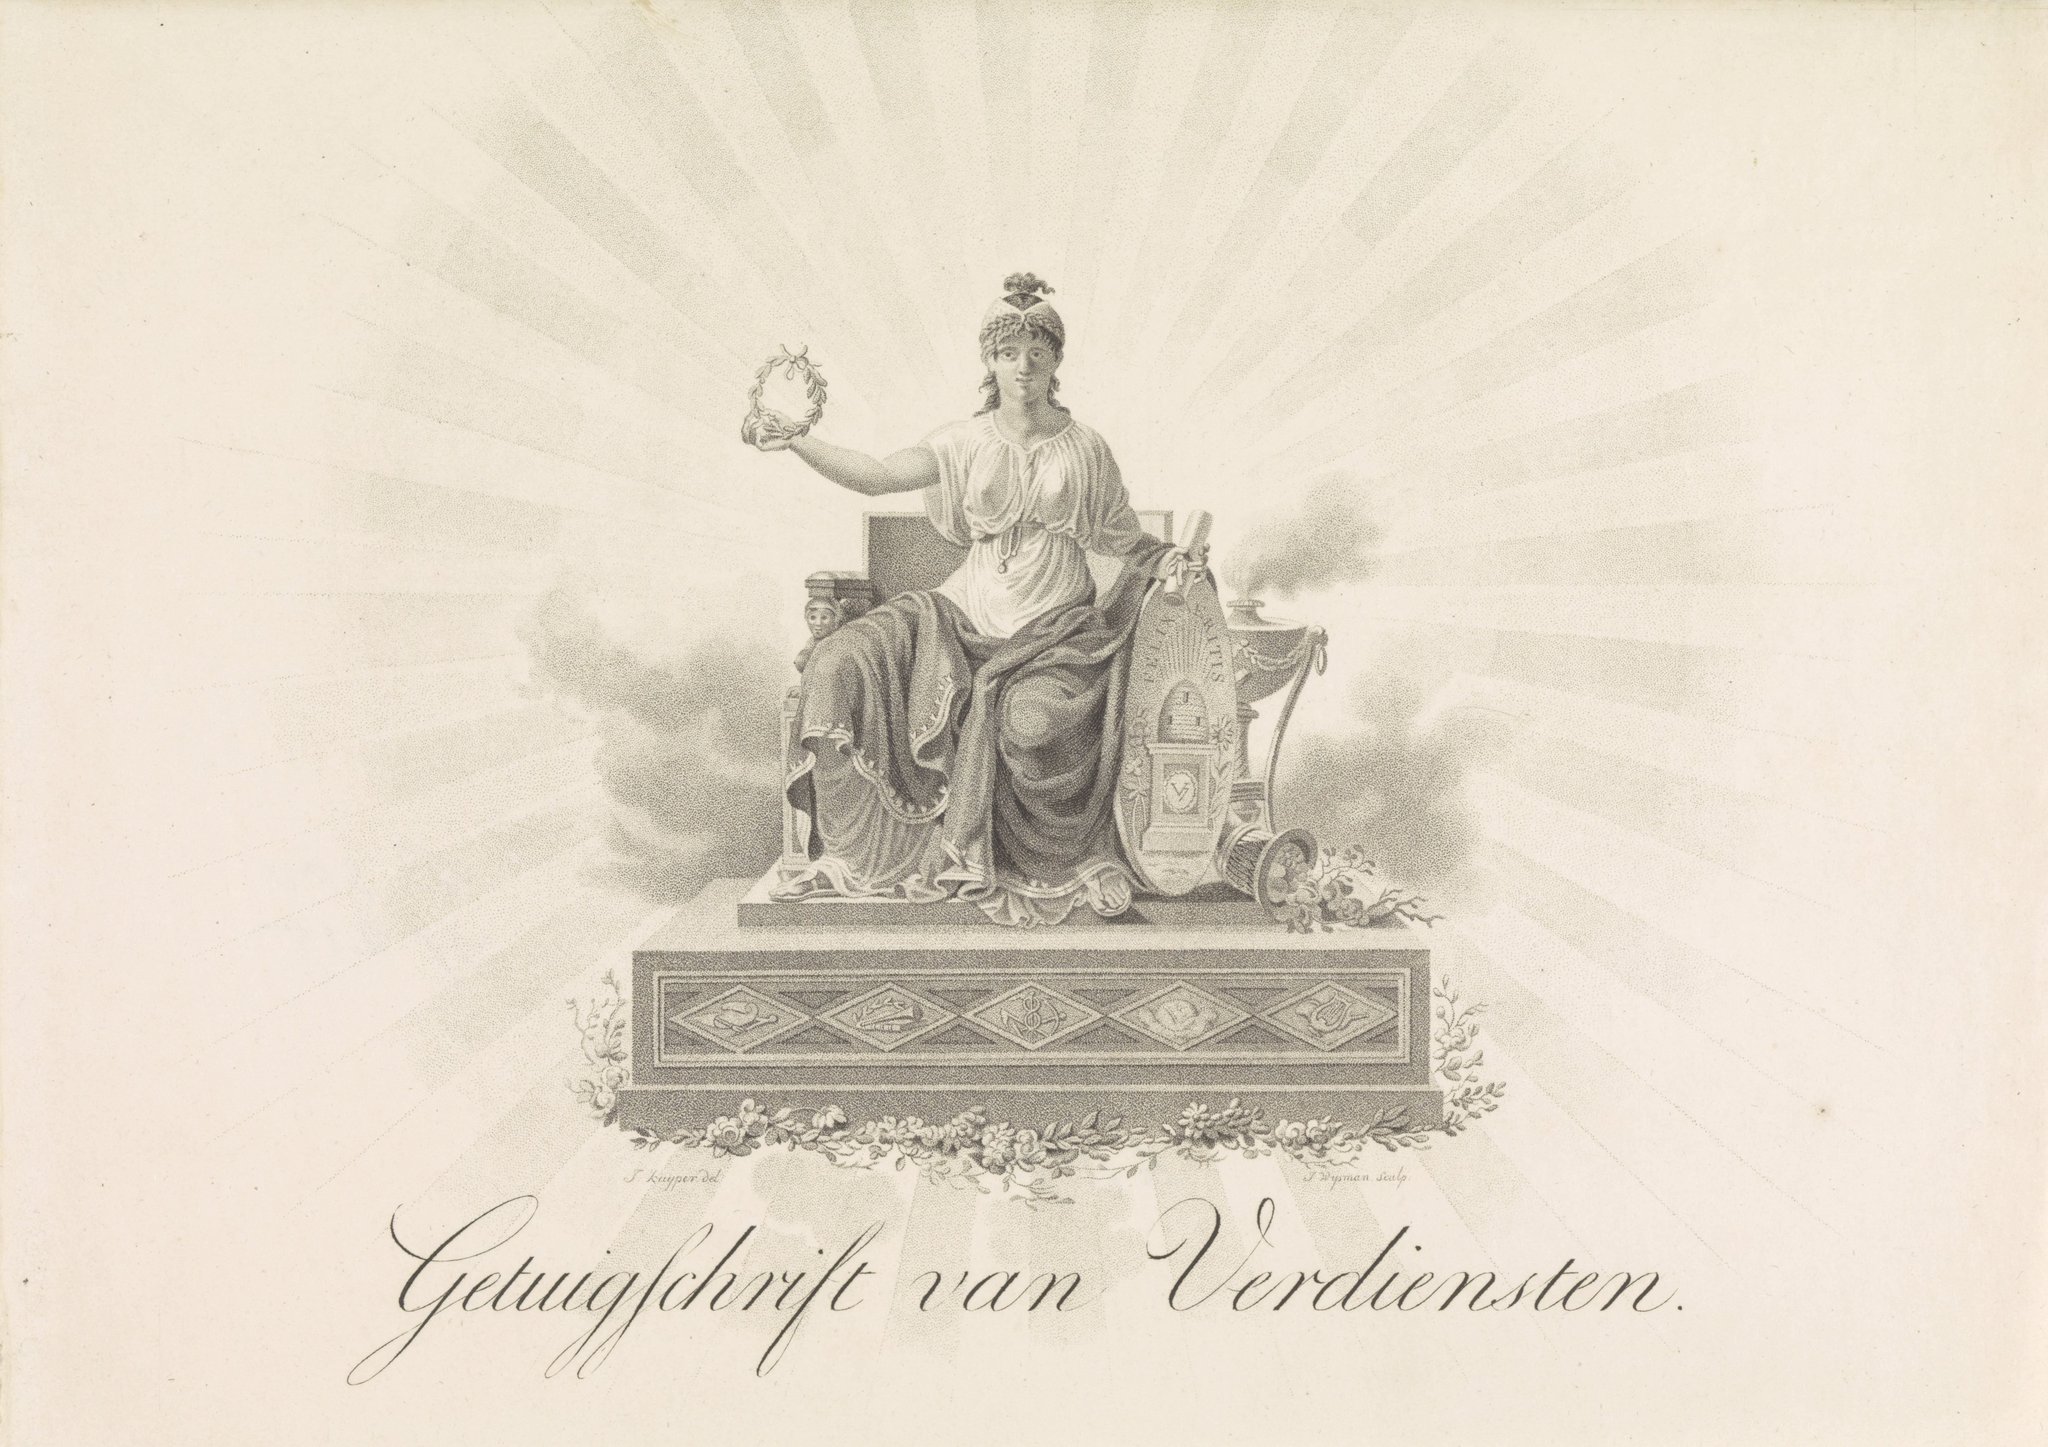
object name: print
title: Getuigschrift van Verdiensten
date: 1778-1827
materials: paper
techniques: etching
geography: amsterdam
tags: 'cornucopia', horn of plenty, crowning with laurel, amsterdam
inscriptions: collector's mark: Lugt 2228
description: Getuigschrift van Felix Meritis te Amsterdam. De personificatie van Felix Meritis rust met de linkerhand op een ovaal schild, waarop het symbool van de Maatschappij. Met de rechterhand reikt zij een lauwerkrans uit. Naast haar staat een reukaltaar en ligt een hoorn des overvloeds.